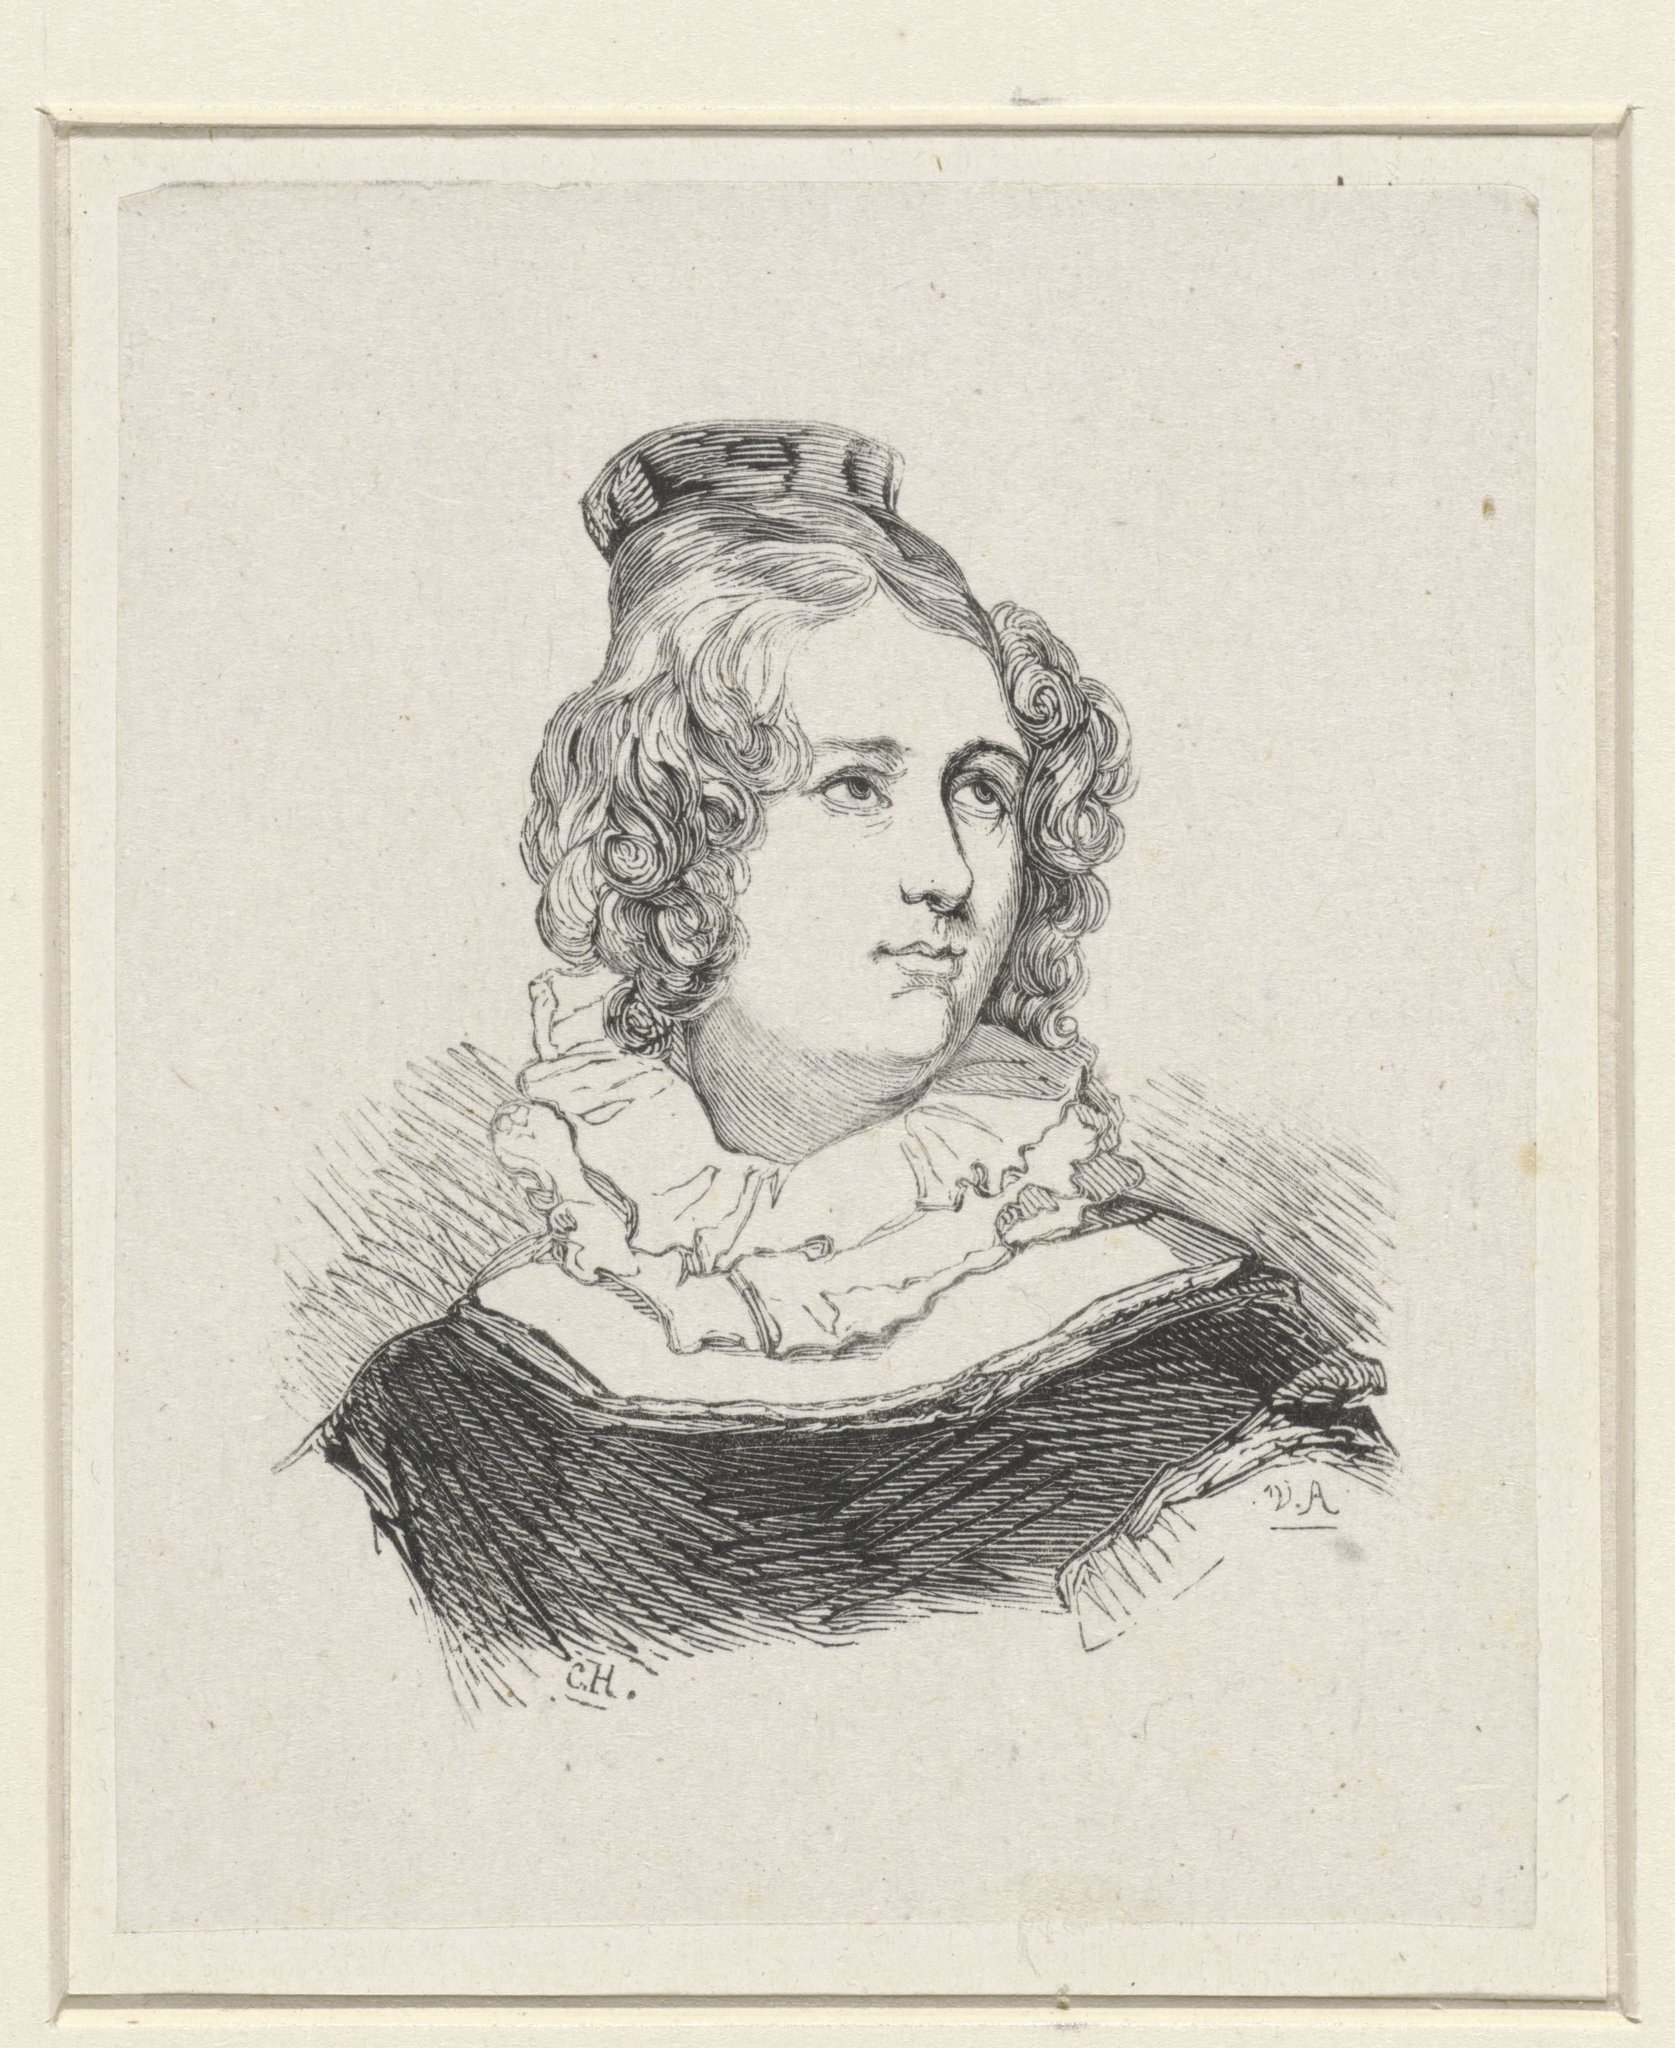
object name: print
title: Portret van Charlotte Hay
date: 1842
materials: paper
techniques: engraving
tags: charlotte hay, historical persons - bb - woman, portrait, self-portrait of painter, portrait, self-portrait of artist, portrait, self-portrait of draughtsman